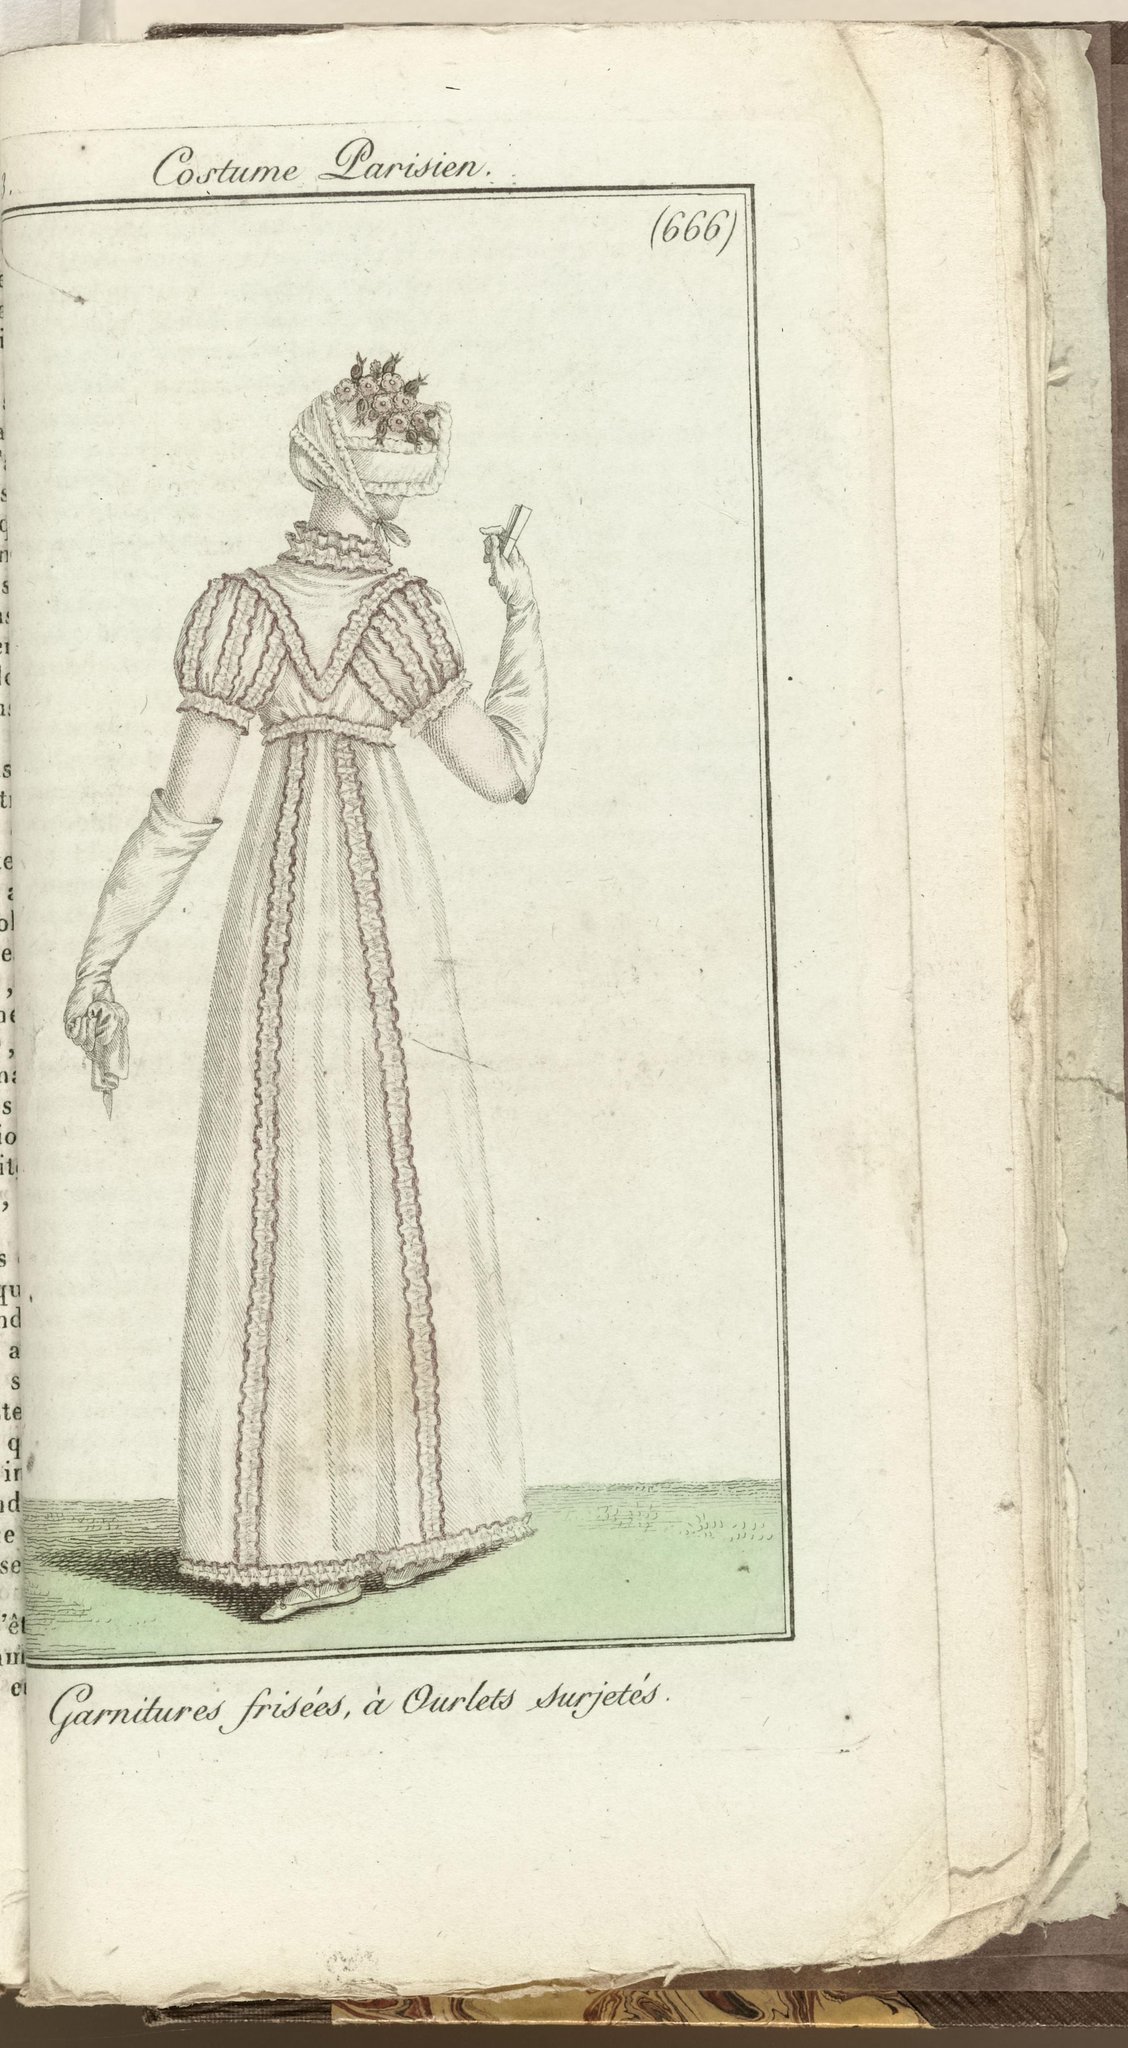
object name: fashion print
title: Journal des Dames et des Modes, Costume Parisien, 1805, An 13 (666) Garnitures frisées...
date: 1805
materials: paper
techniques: engraving, hand coloring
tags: head-gear (capote) (+ women's clothes), gloves, mittens (long gloves) (+ women's clothes), fashion plates, dress, gown (+ women's clothes)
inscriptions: title: ‘Garnitures frisées, à Ourlets surjetés’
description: Vrouw op de rug gezien, in een witte japon met rood borduursel. Lange handschoenen. Hoedje met bloemen.